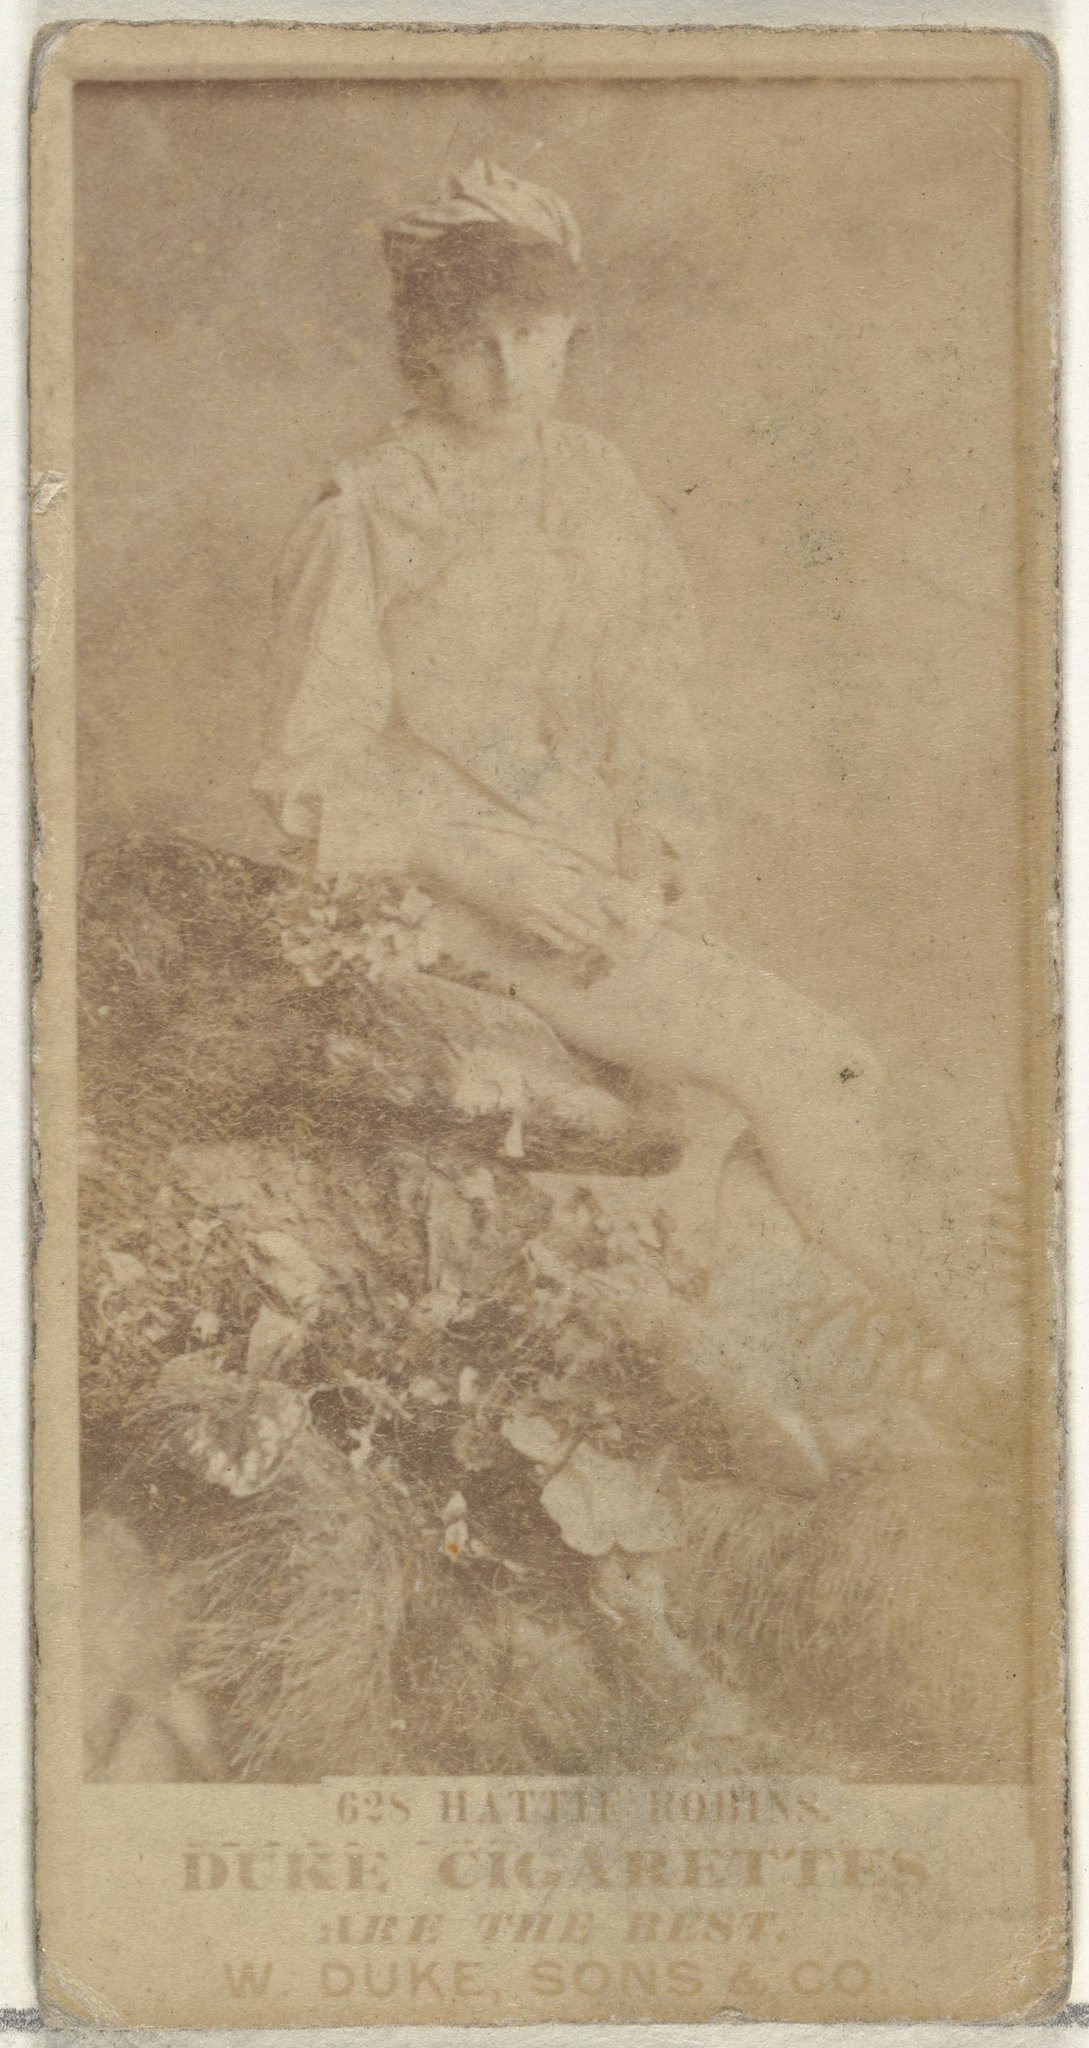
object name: photograph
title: Card Number 628, Hattie Robins, from the Actors and Actresses series (N145-7) issued by Duke Sons & Co. to promote Duke Cigarettes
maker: w. duke, sons & co.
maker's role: publisher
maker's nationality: american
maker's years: 1870-1920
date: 1880-1889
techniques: albumen silver print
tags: portraits,women,actresses